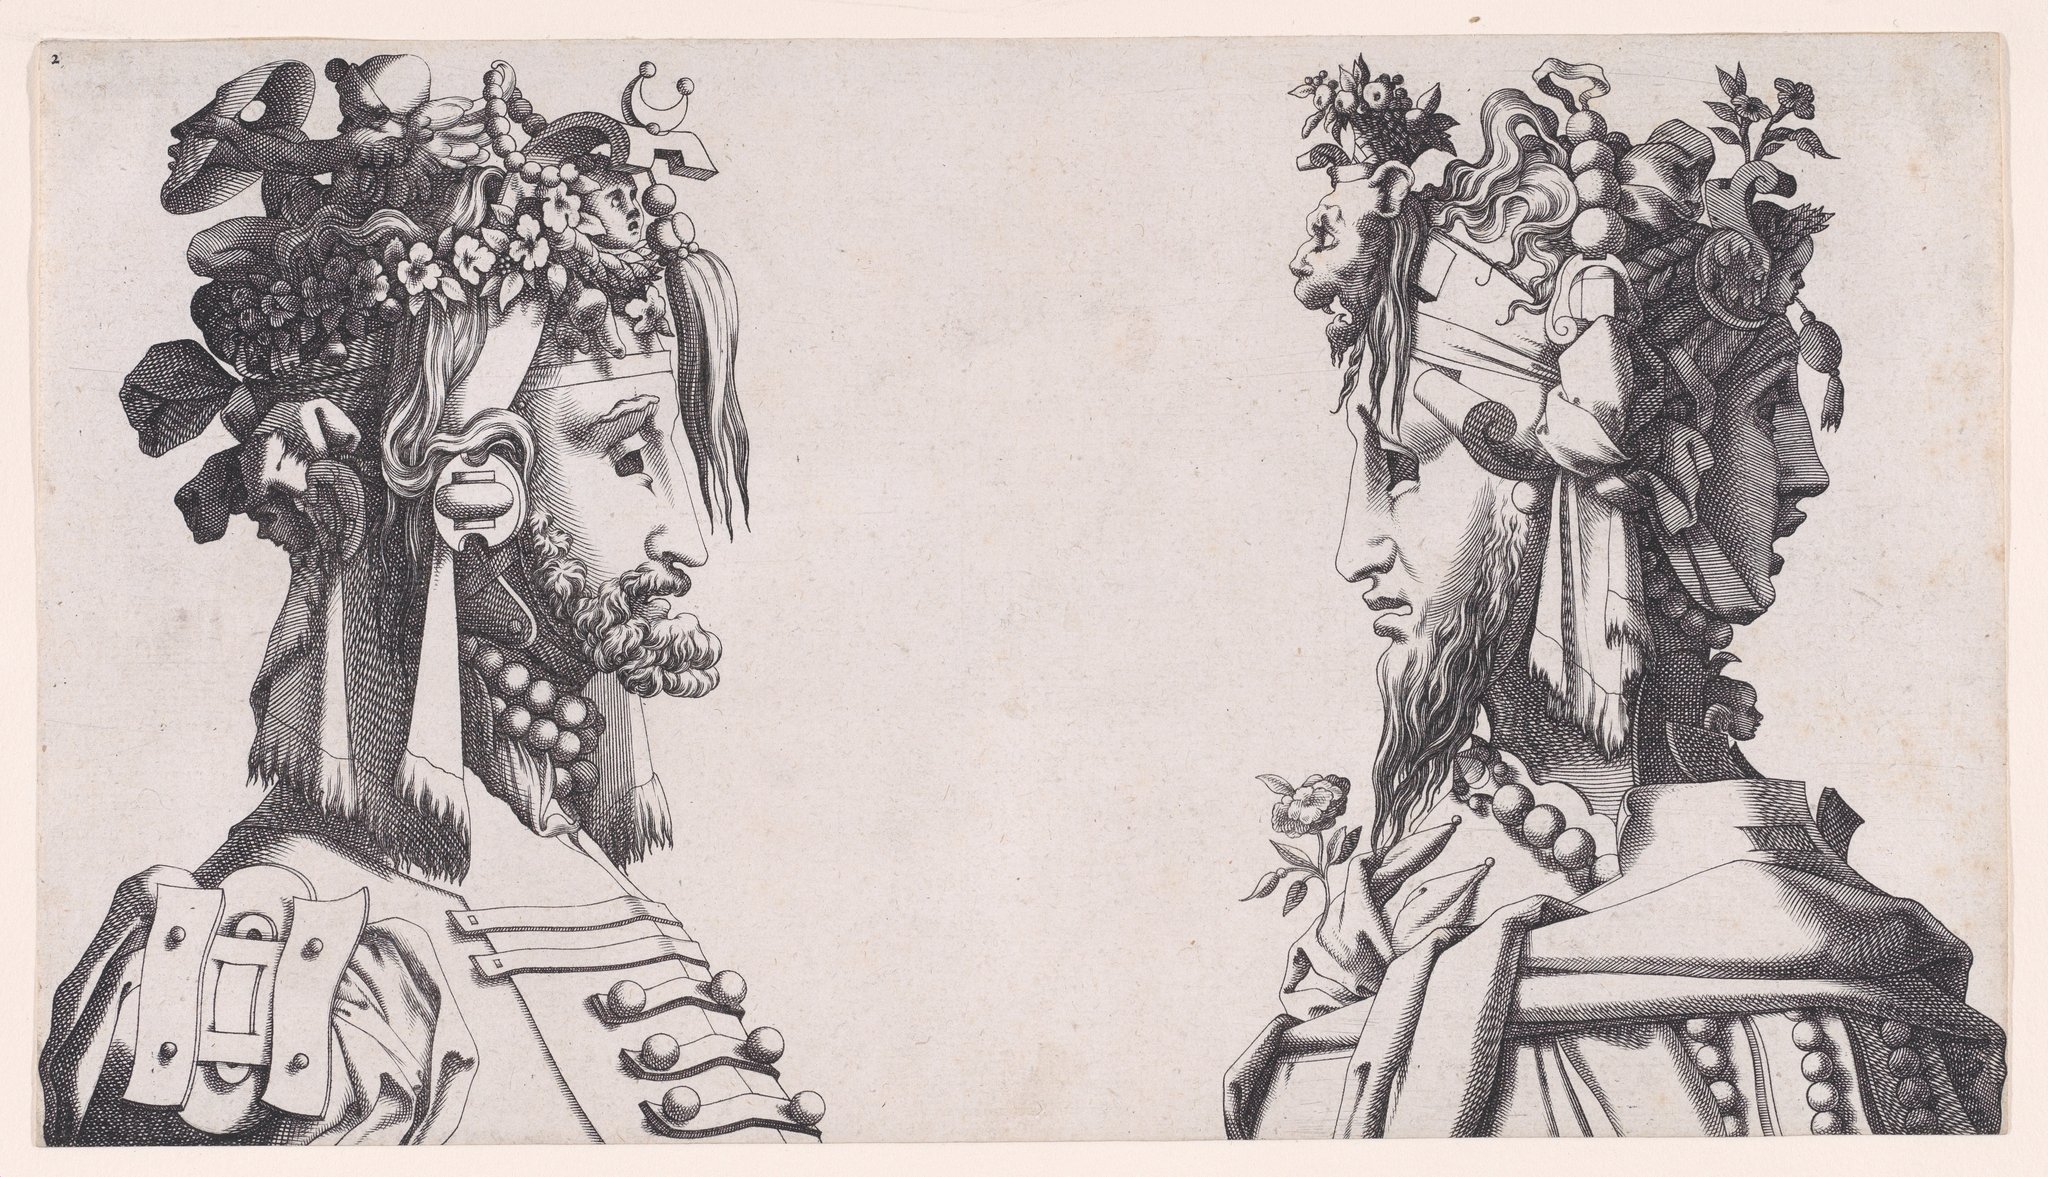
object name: print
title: Two Male Busts with Head-dresses for the Ballet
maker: rené boyvin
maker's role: artist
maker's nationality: french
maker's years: 1525-1598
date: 1501-1600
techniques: engraving